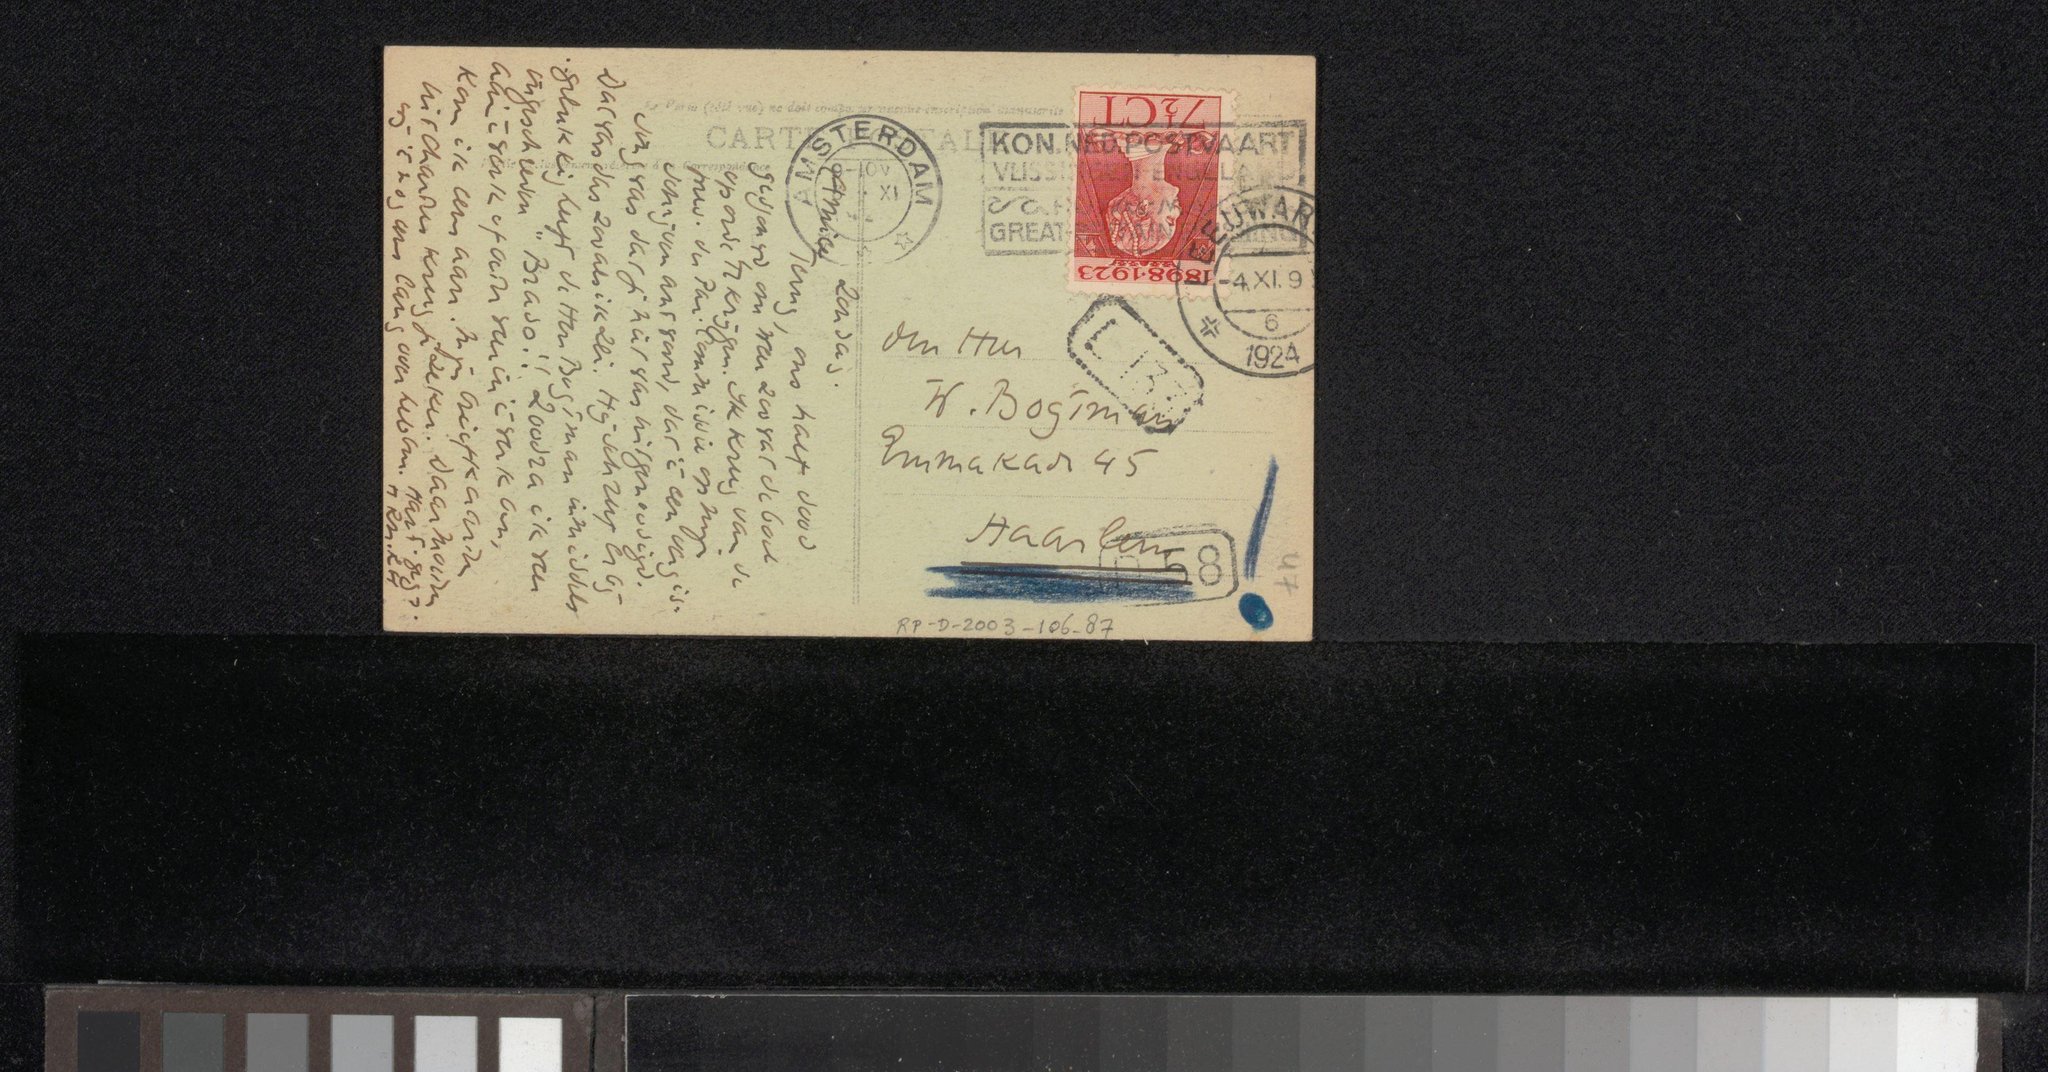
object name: ansichtkaart, prentbriefkaart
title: Prentbriefkaart aan Willem Bogtman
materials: cardboard, ink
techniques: photograph, pen, writing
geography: leeuwarden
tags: willem bogtman, paris